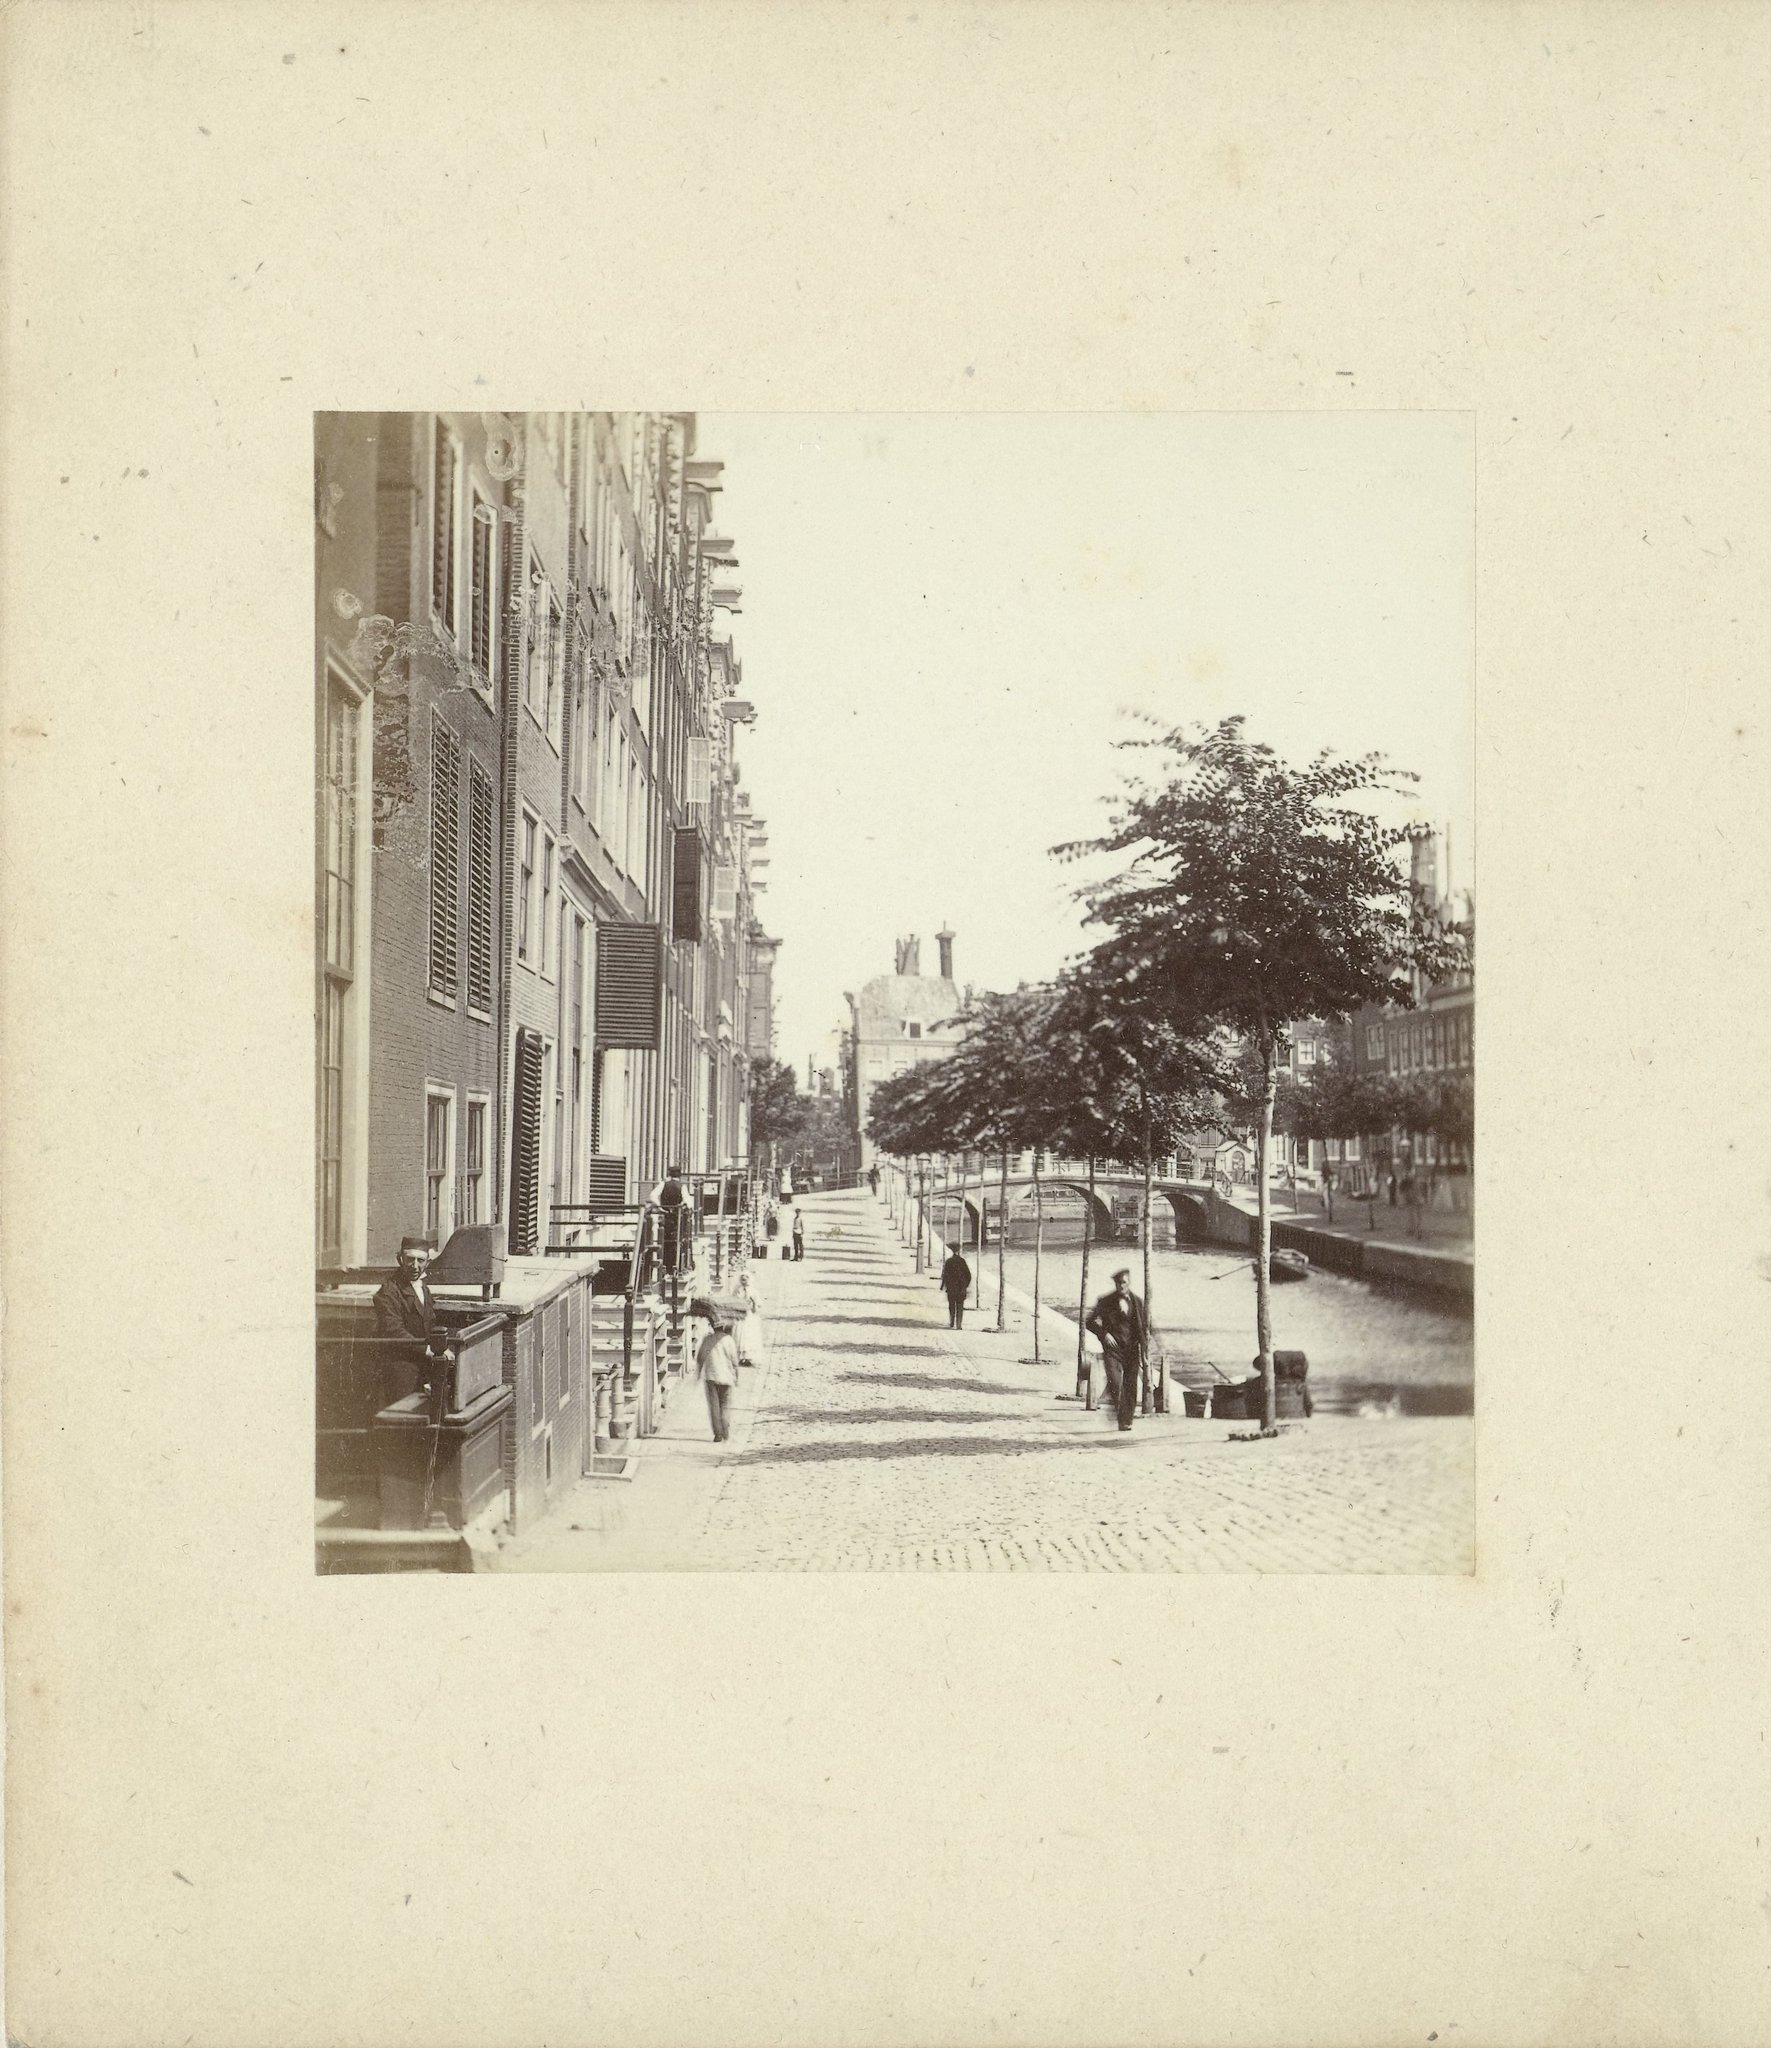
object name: photograph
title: Gezicht op de Leidsegracht in Amsterdam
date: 1860-1875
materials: cardboard, paper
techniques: albumen print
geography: amsterdam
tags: canals, waters (in city)